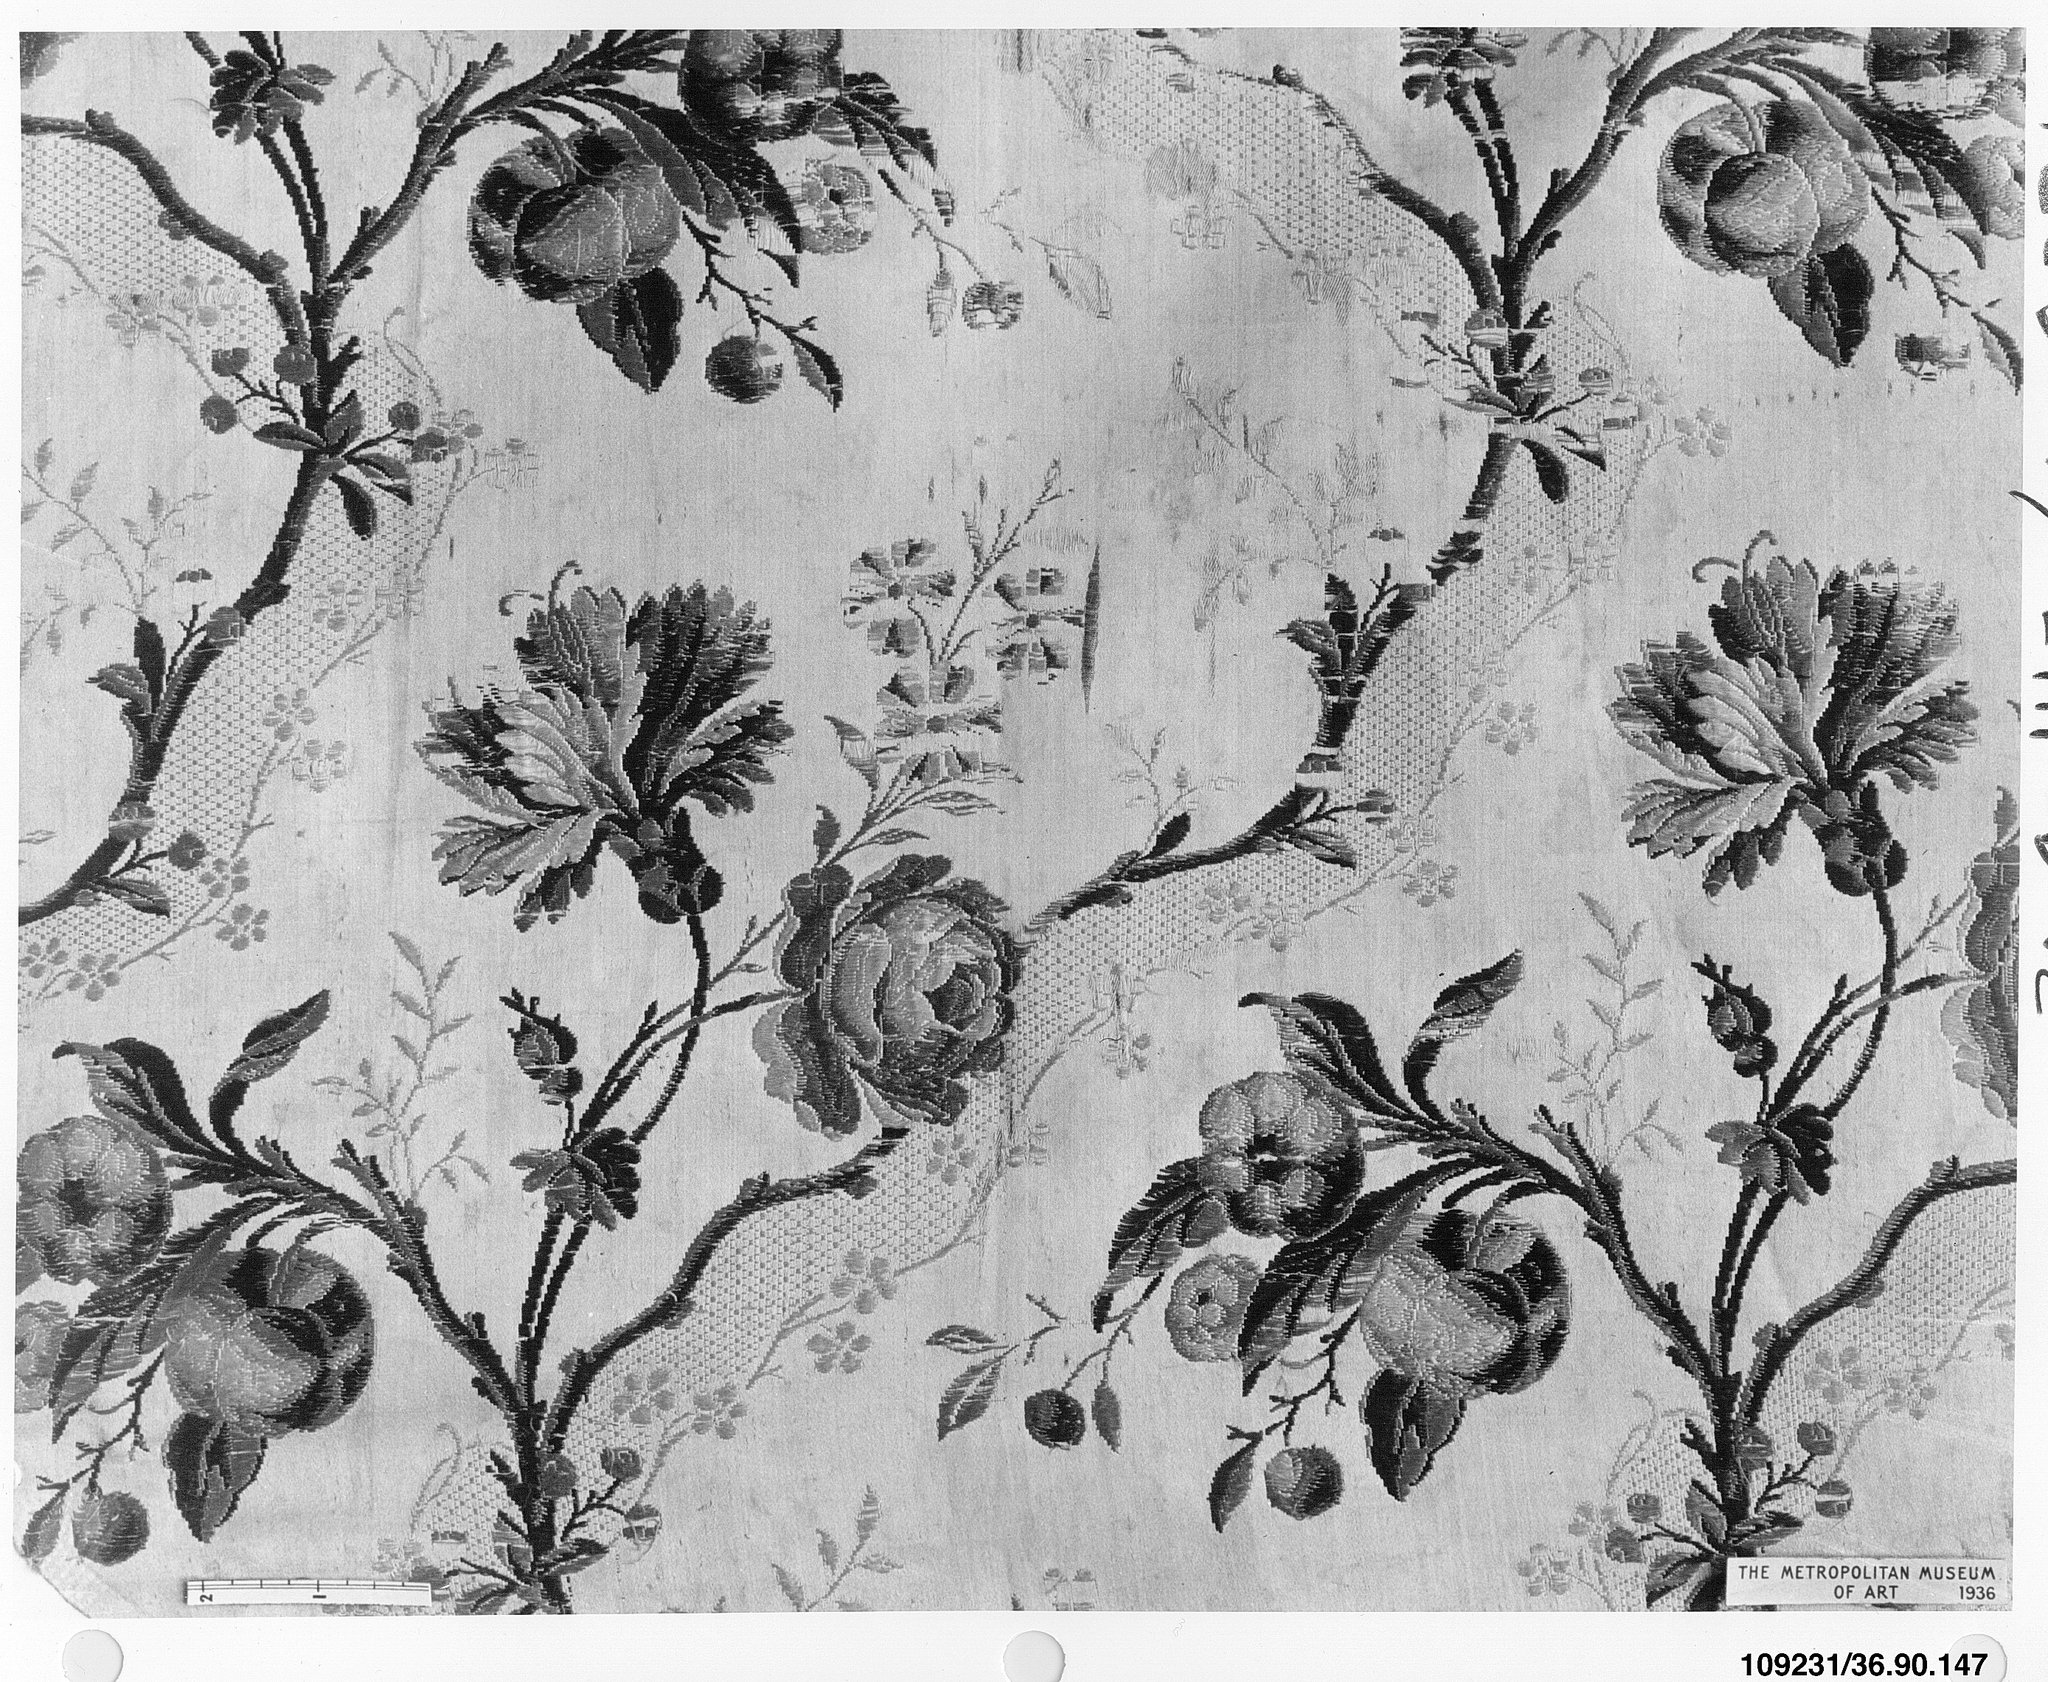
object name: piece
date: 1750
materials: silk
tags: flowers,leaves